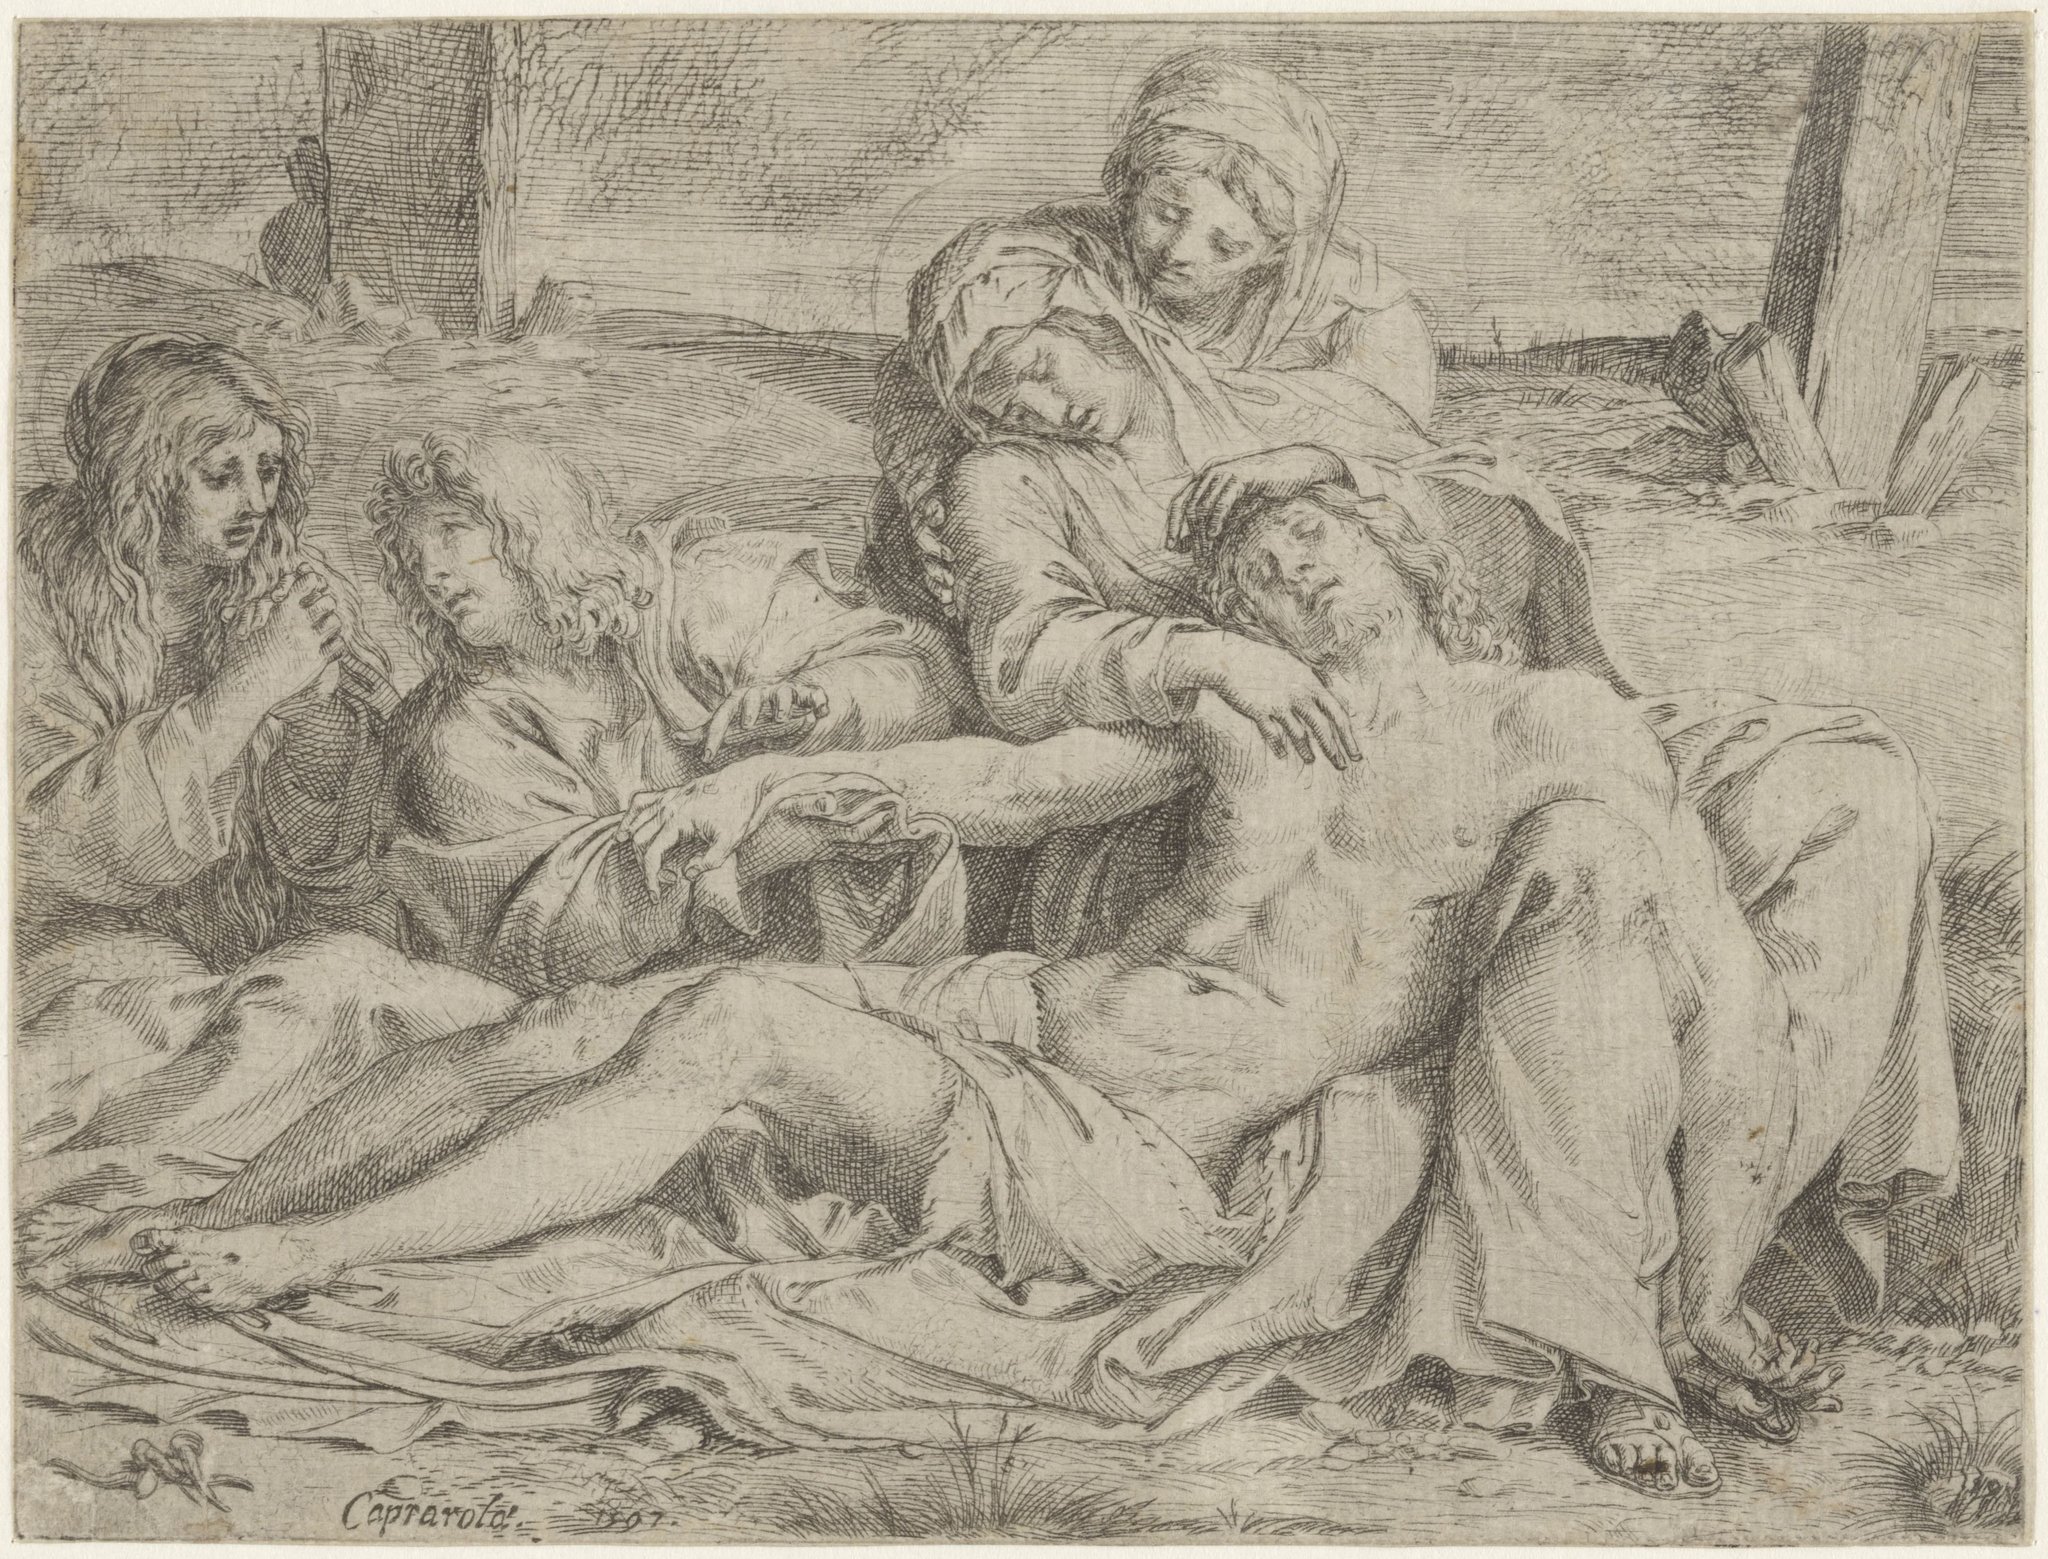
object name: print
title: Bewening van Christus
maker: annibale carracci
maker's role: draughtsman, print maker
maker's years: 1560-1609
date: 1597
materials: paper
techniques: drypoint, engraving, etching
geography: caprarola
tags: the mourning over the dead christ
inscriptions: collector's mark: Lugt 240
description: De Maria's en Johannes de Evangelist treuren bij het dode lichaam van Christus.